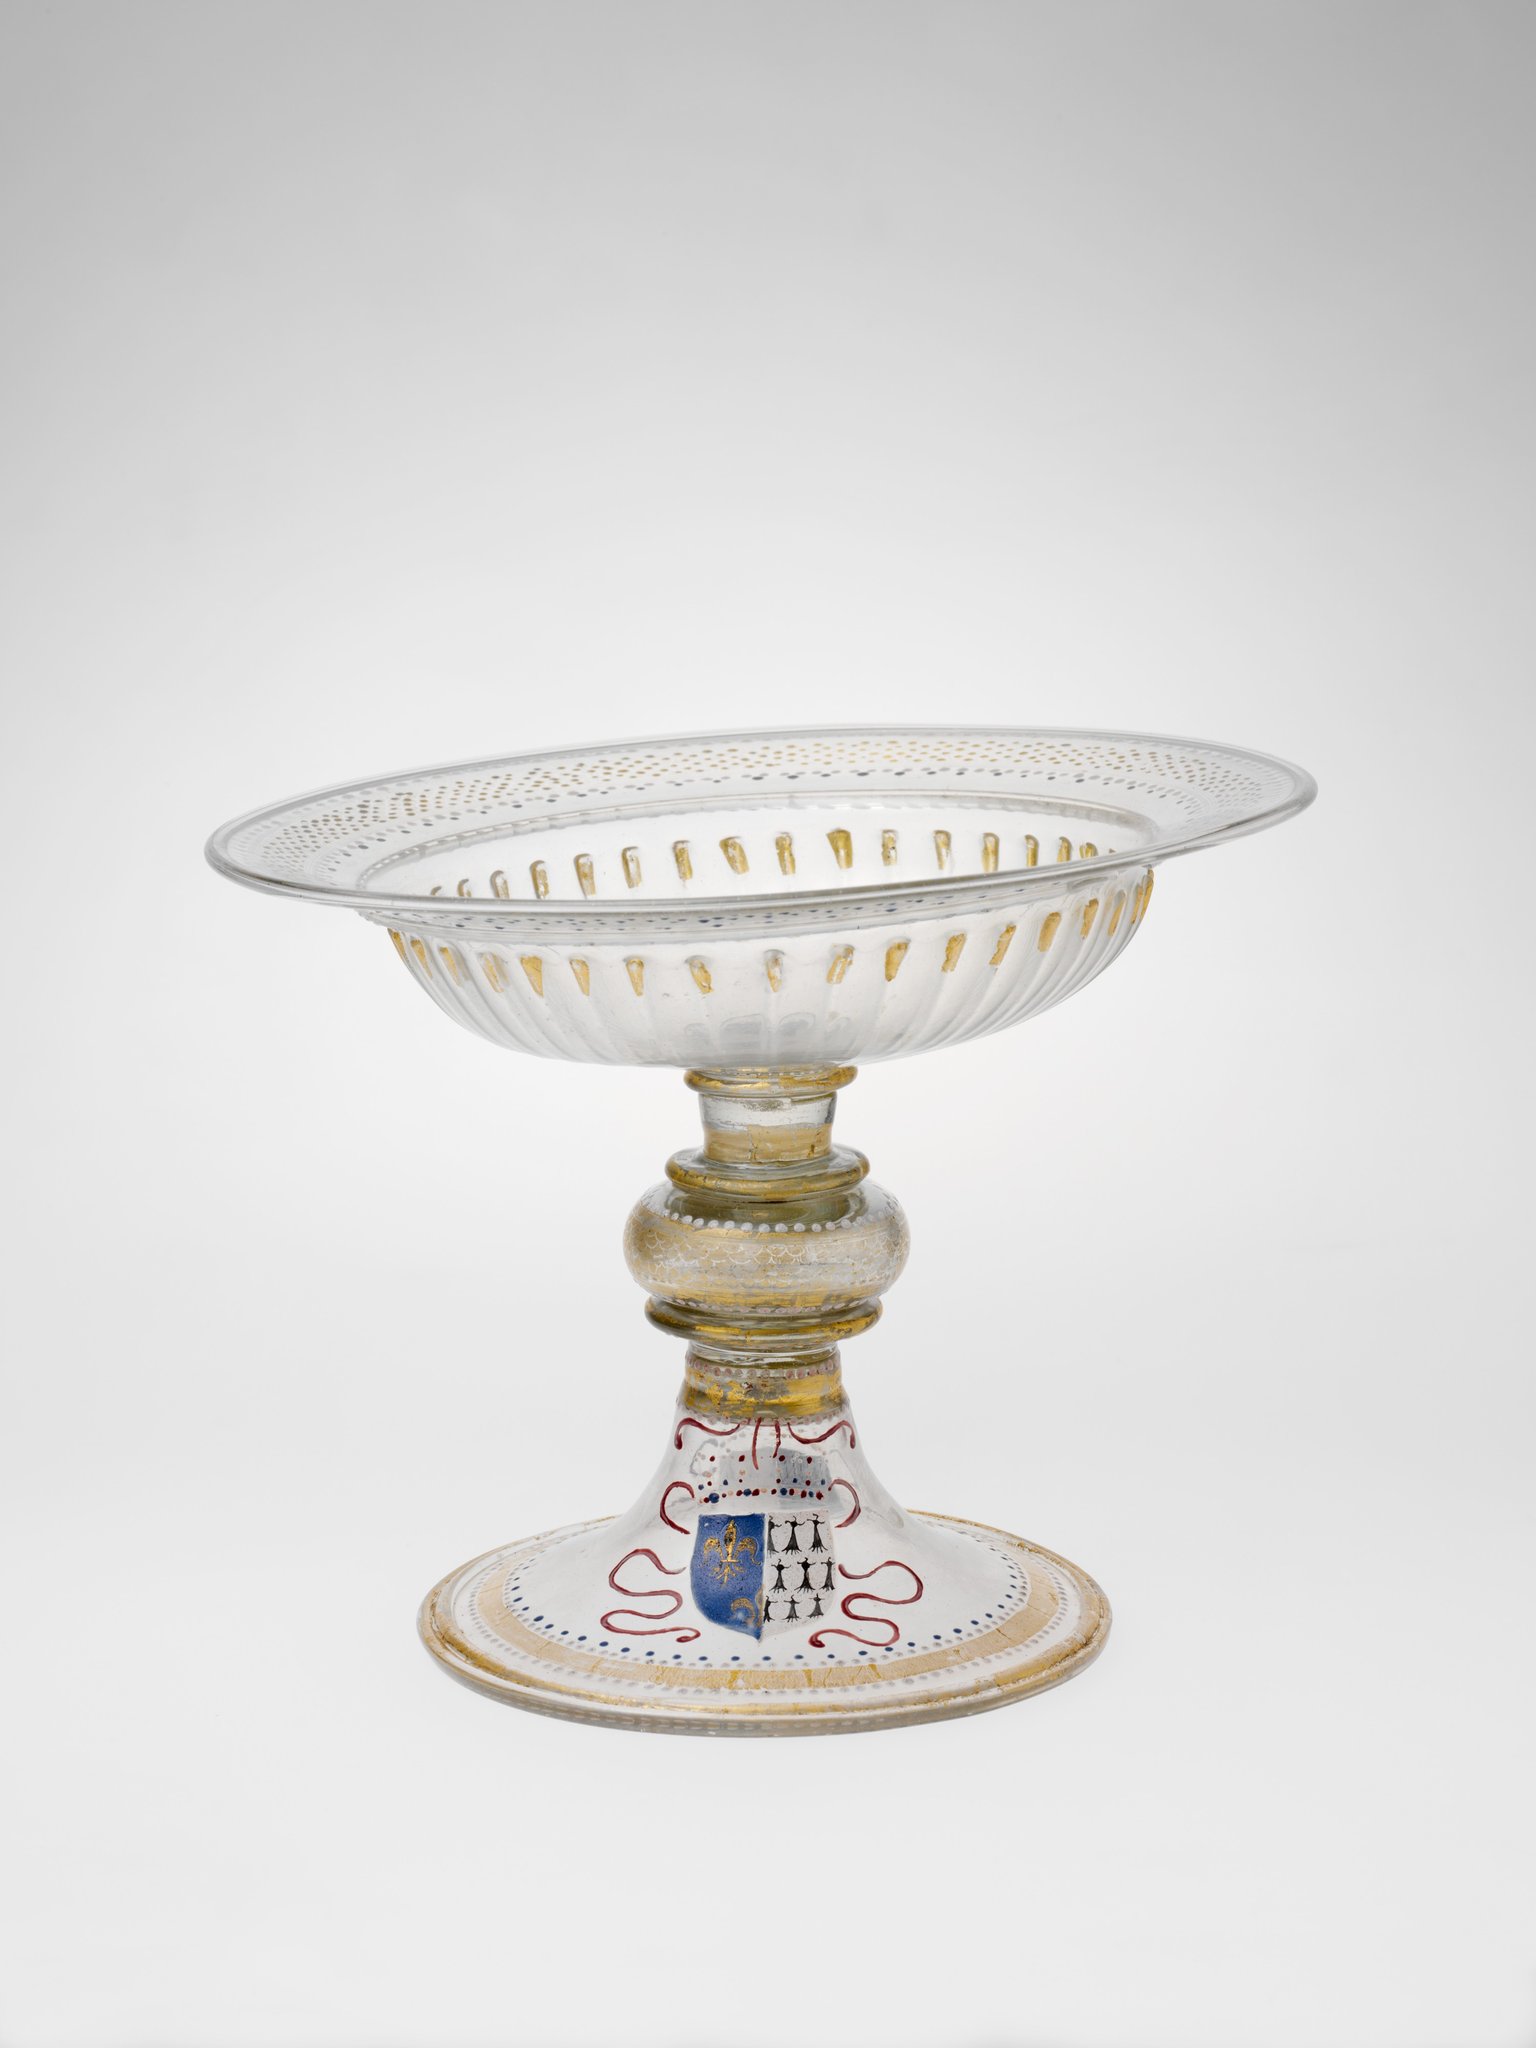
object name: tazza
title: Armorial tazza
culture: venetian or façon de venise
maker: italian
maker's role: artist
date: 1499-1514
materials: gilt, glass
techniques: glassblowing, enamel, molding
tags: coat of arms